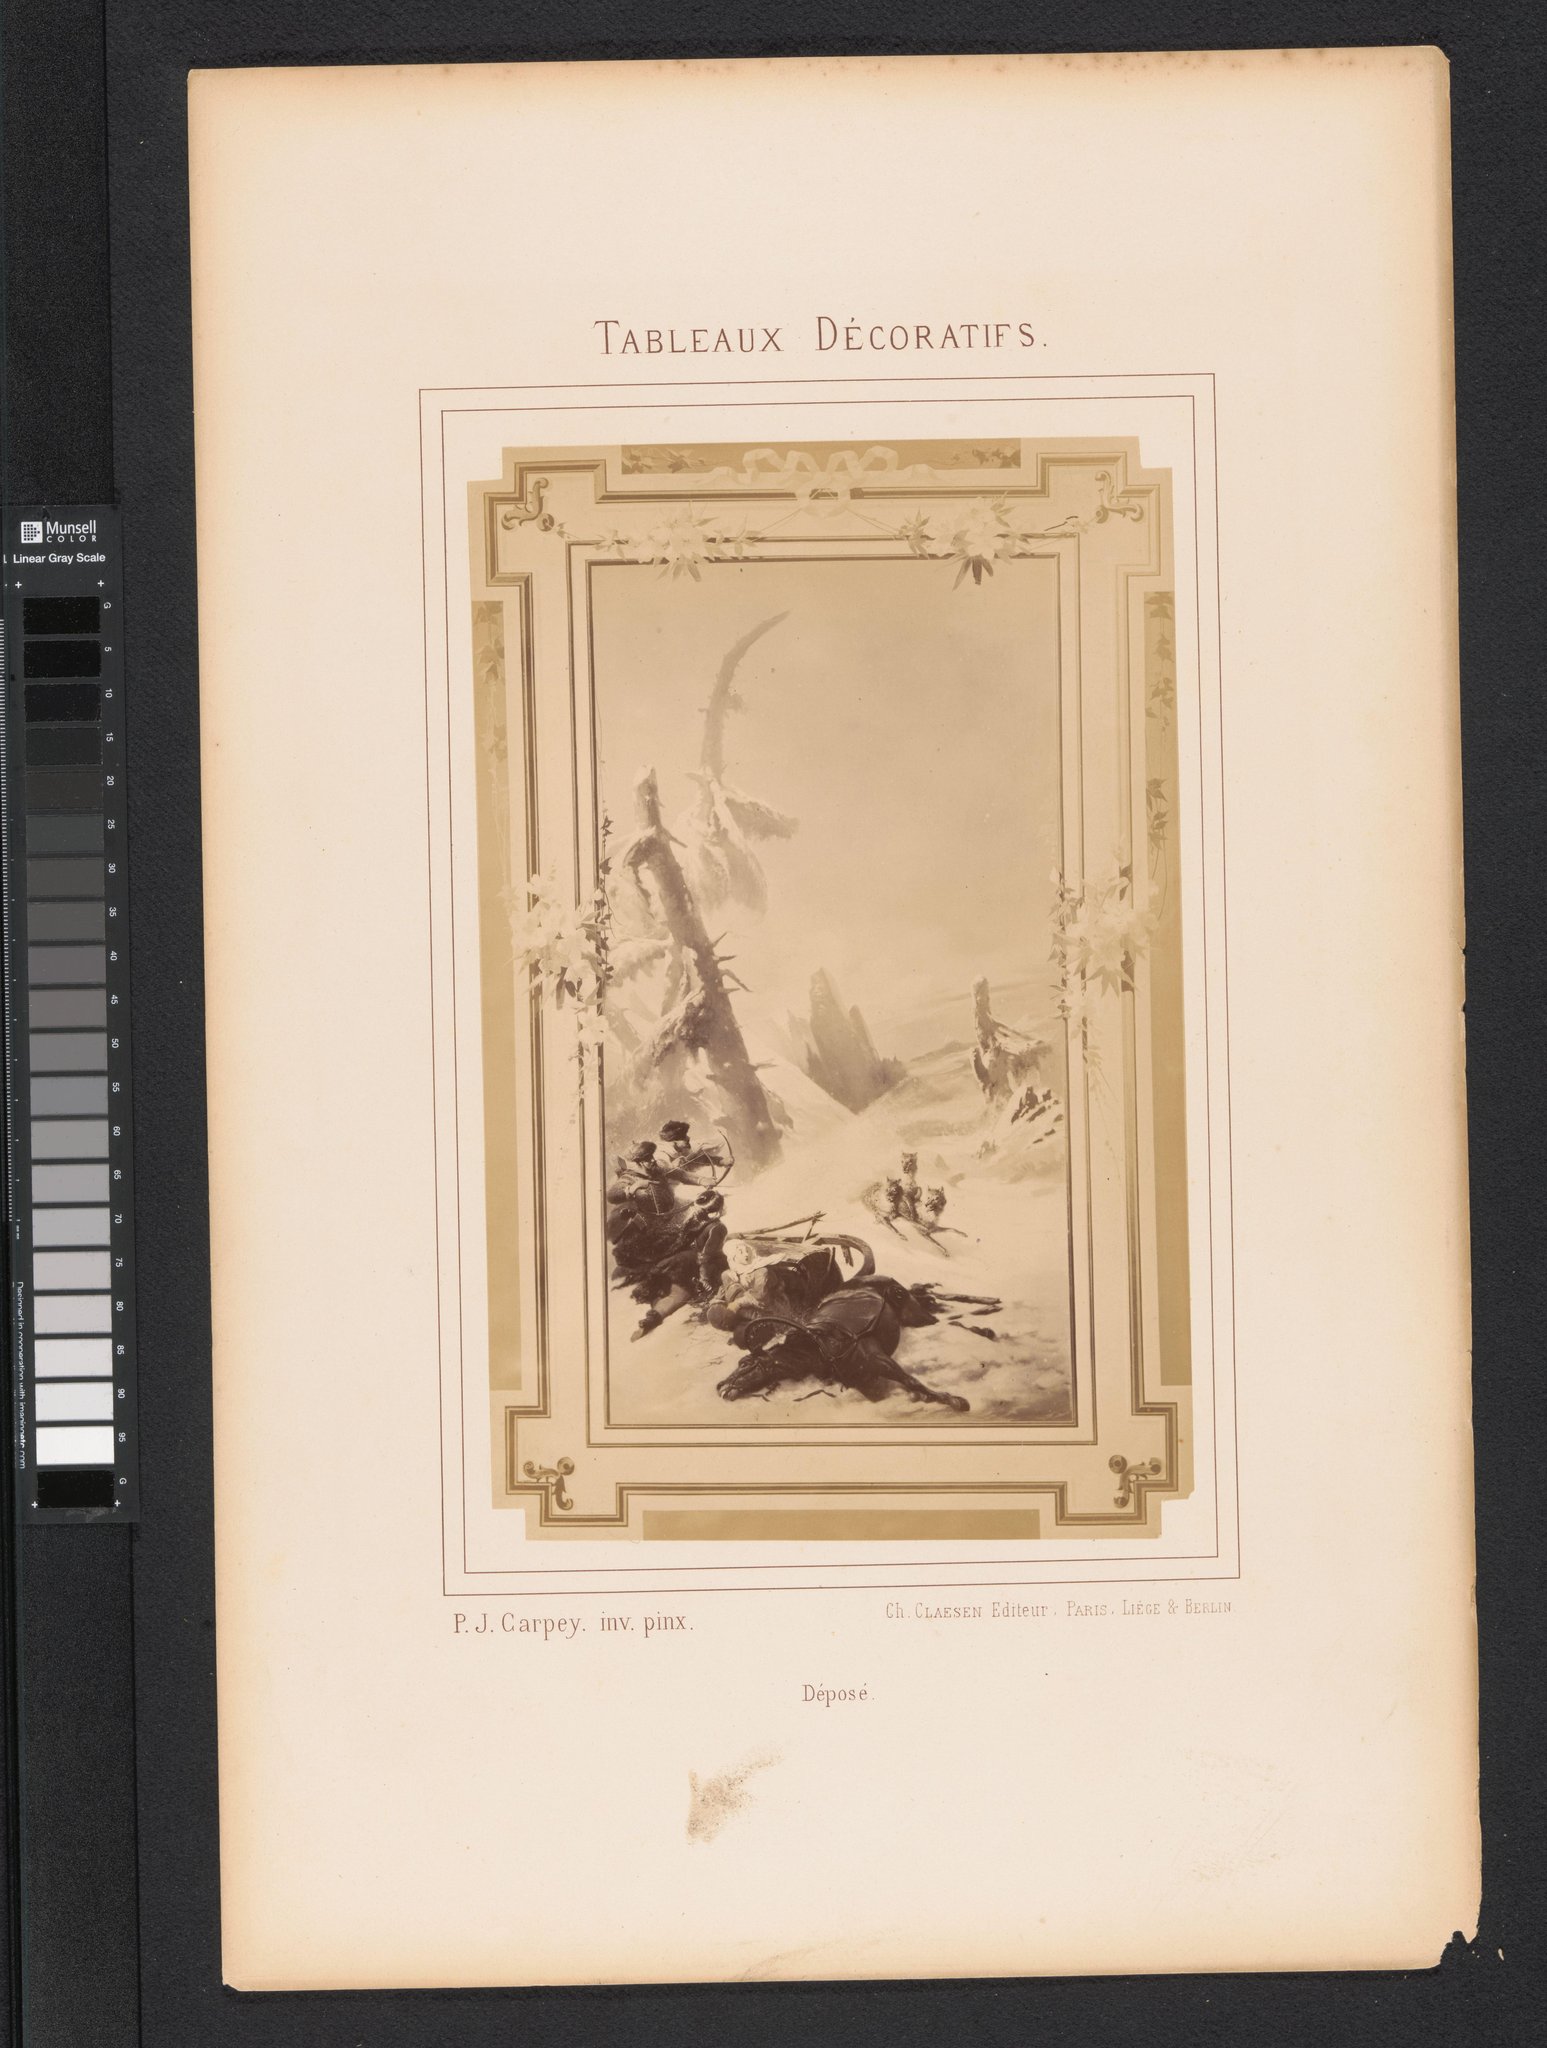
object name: photograph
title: Tableaux Décoratifs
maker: paul-joseph carpay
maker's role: painter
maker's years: 1822-1892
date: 1874-1881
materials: photographic support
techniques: albumen print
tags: beasts of prey, predatory animals: wolf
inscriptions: inscription: ‘Ch. Claesen Editeur , Paris , Liége & Berlin’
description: Deze foto maakt deel uit van een omslag met 24 foto's op 22 bladen.